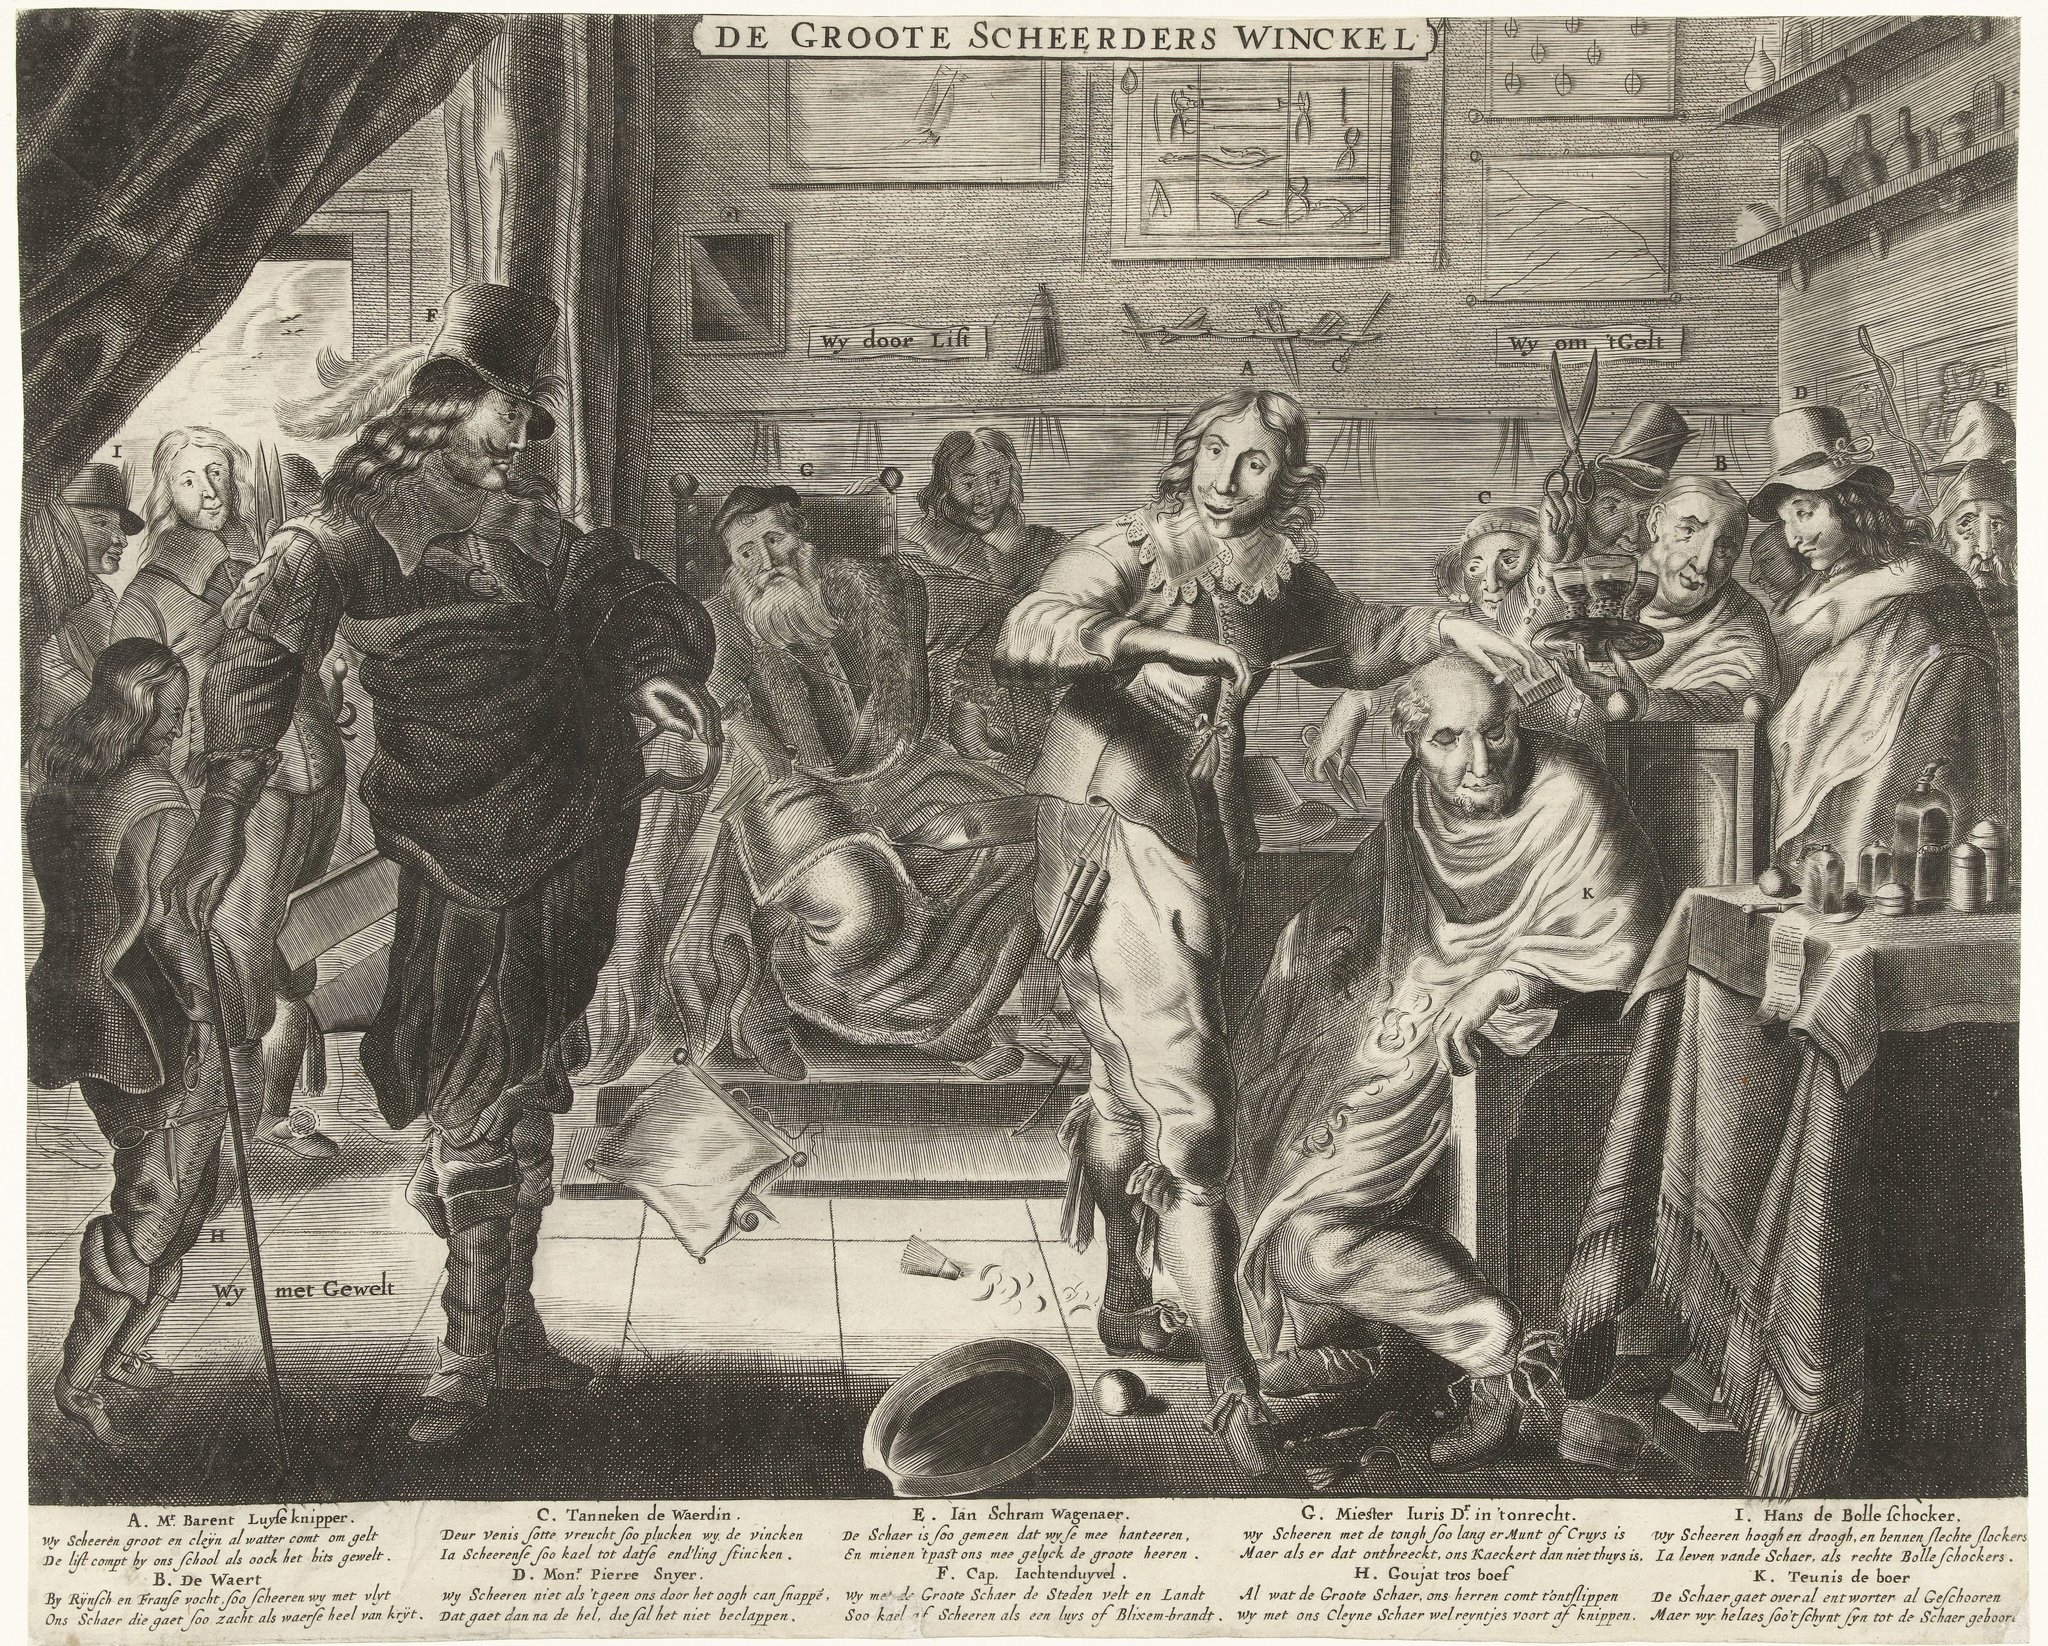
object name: print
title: De Groote Scheerders Winckel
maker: Anonymous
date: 1640-1660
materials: paper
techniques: engraving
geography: low countries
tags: farmers, barber, barbershop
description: De boer in de grote barbierswinkel. In een kapperswinkel wordt een Teunis de boer door mr. Barent Luyseknipper geknipt. In de zaak zijn meerdere personen met scharen aanwezig die ook graag de boer willen knippen en scheren. In het onderschrift de namen van de personages in de voorstelling gemerkt A-K met bij elke naam een tweeregelig vers. Spotprent op het lot van de boer die altijd het slachtoffer is, in tijden van oorlog maar ook van vrede.